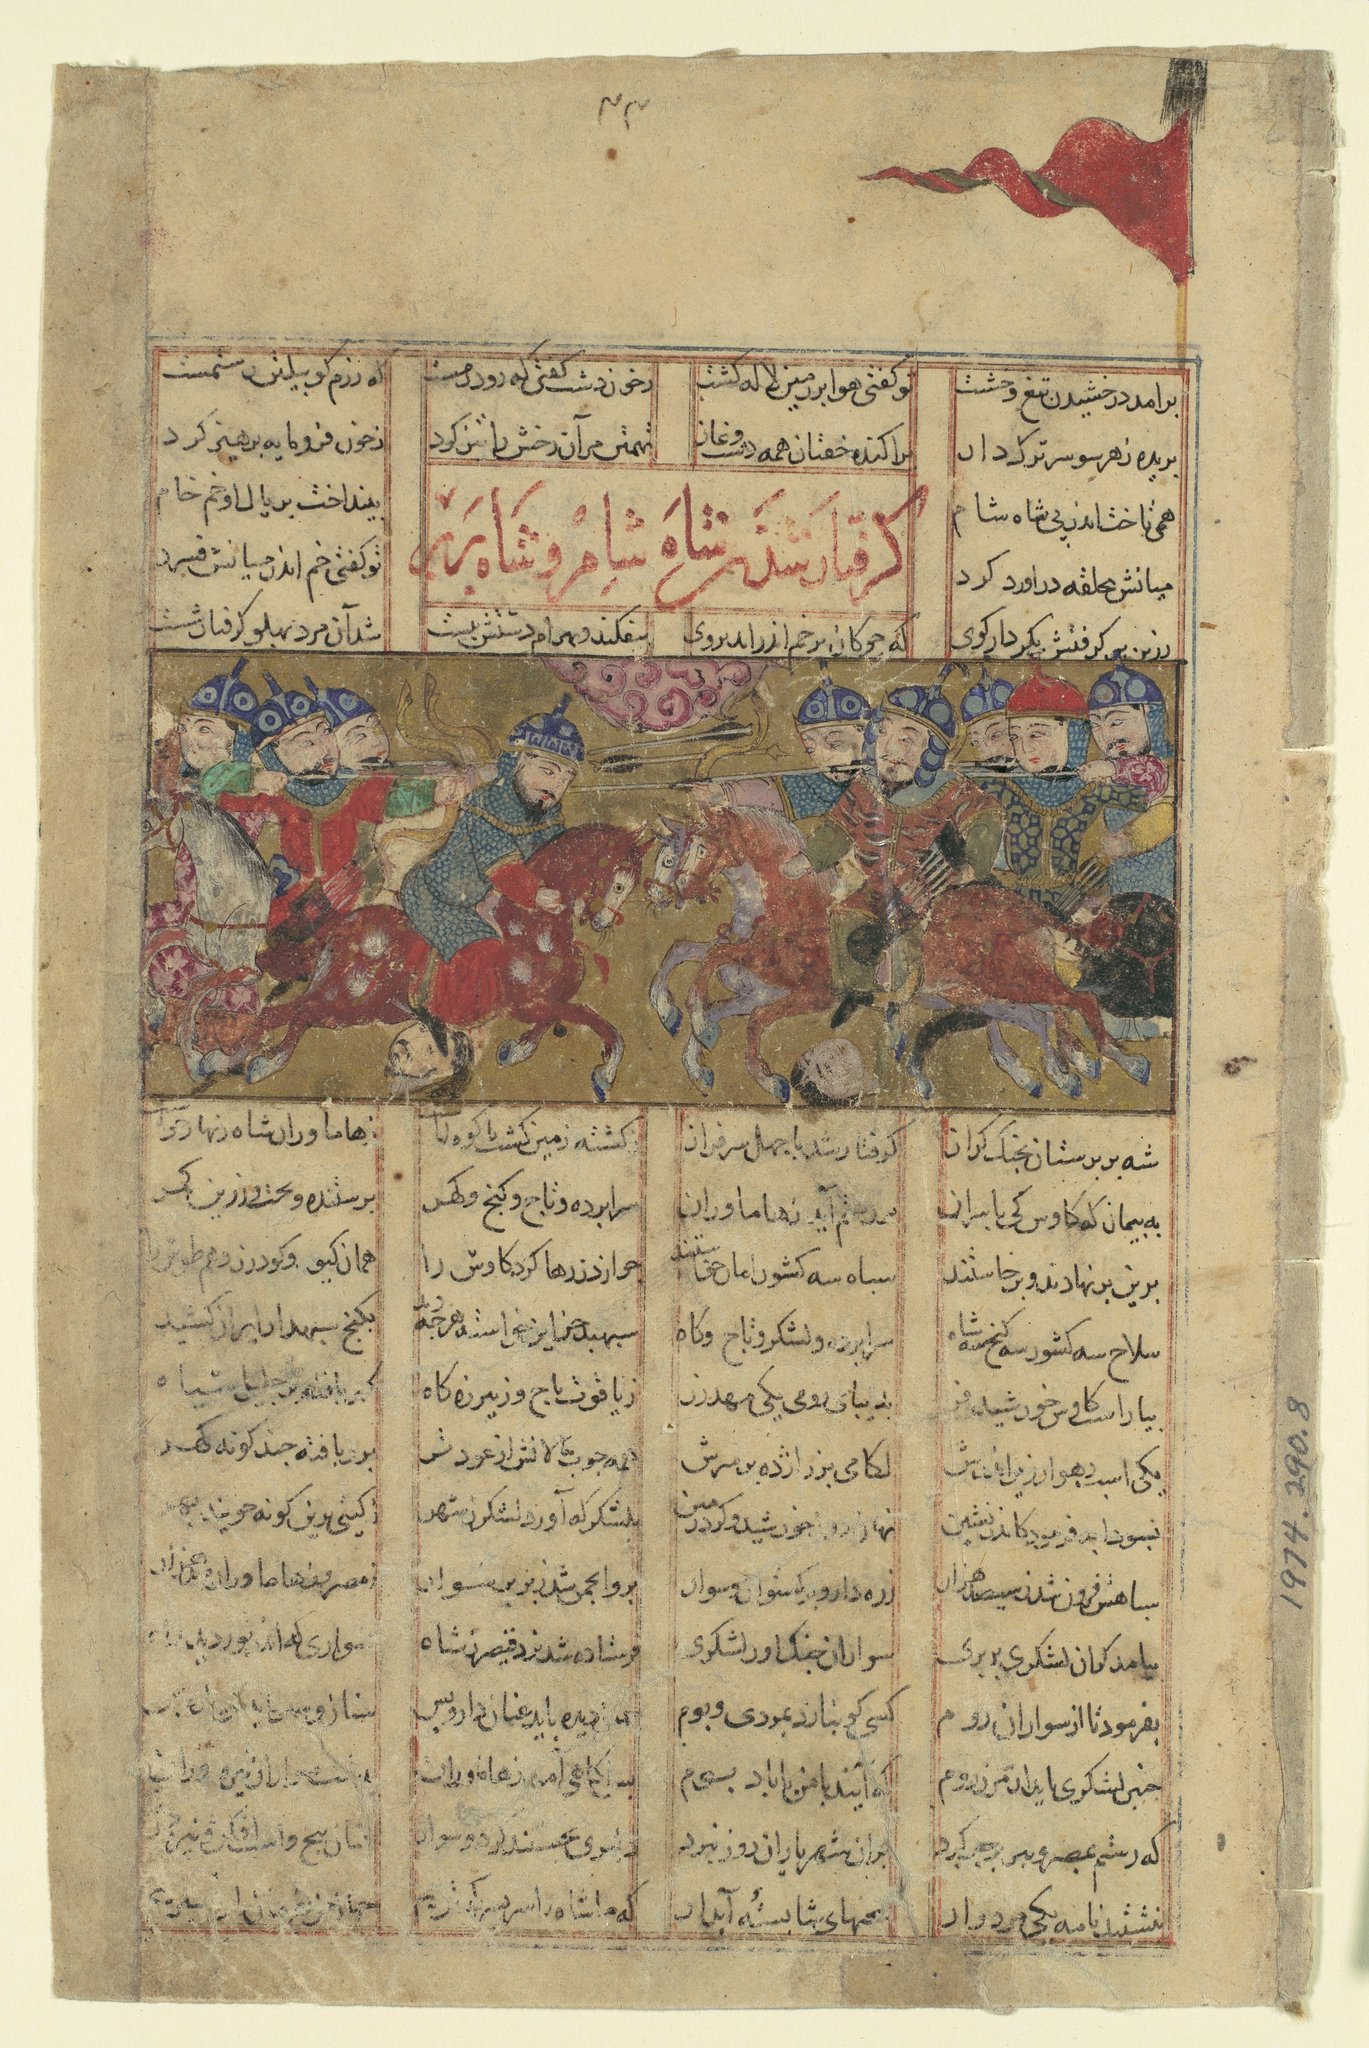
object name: folio from an illustrated manuscript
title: "Rustam Captures the Shah of Sham and the Shah of Berber", Folio from a Shahnama (Book of Kings) of Firdausi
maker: abu'l qasim firdausi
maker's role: author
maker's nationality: iranian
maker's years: 935-1020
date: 1330-1340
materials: gold, ink, paper, silver, watercolor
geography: iran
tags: battles,army,men,horses